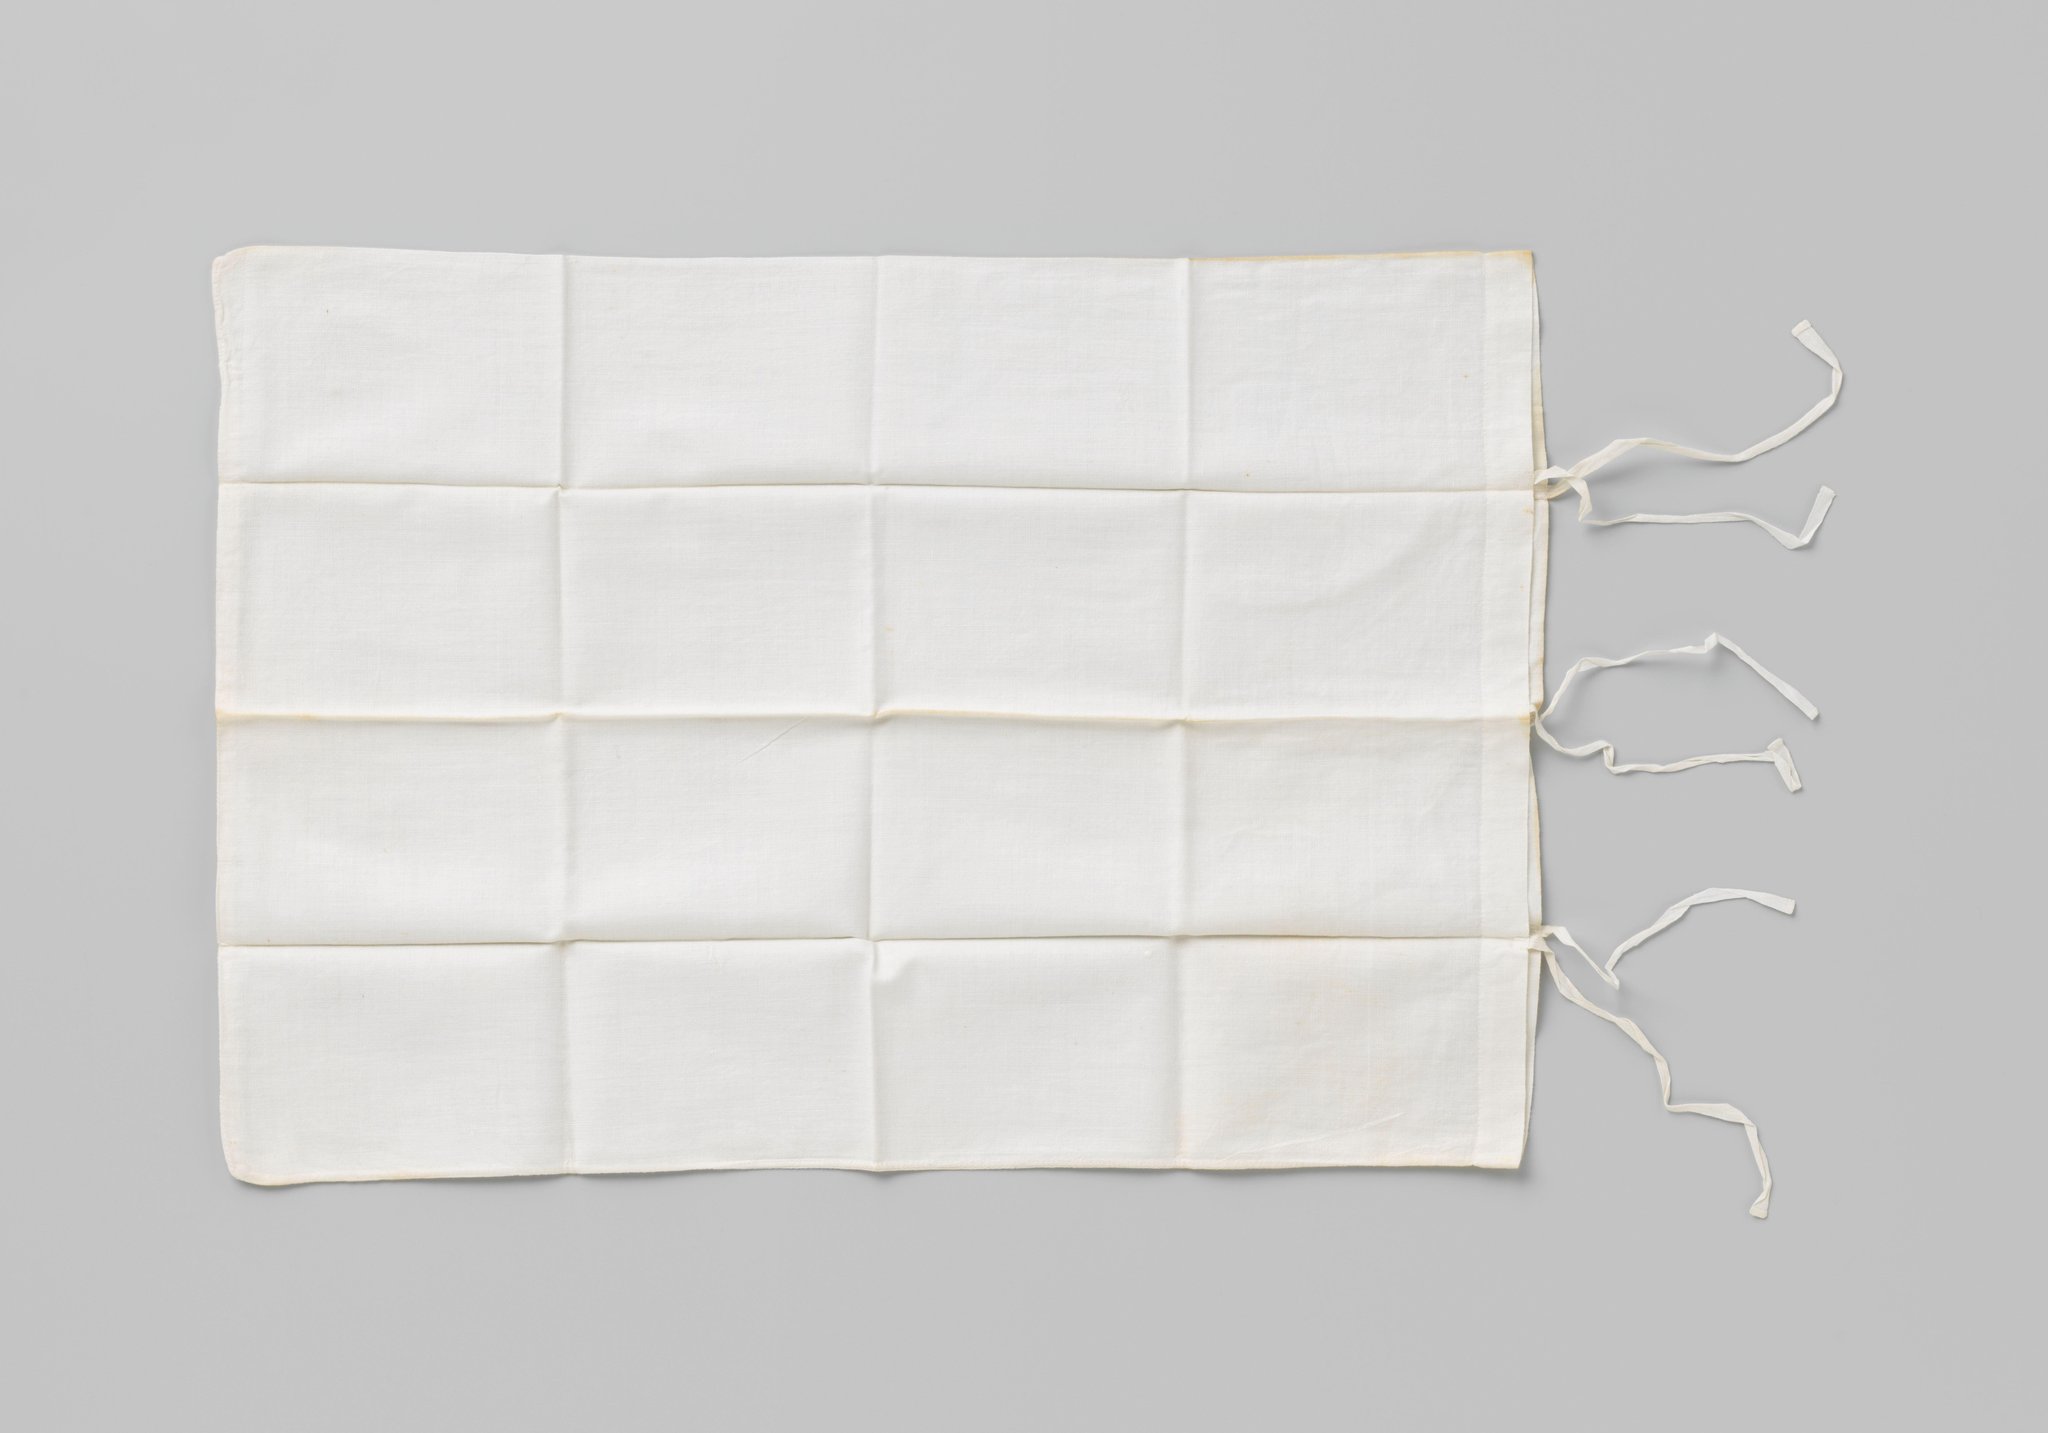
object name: lendensloop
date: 1820-1870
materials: cotton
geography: northern netherlands